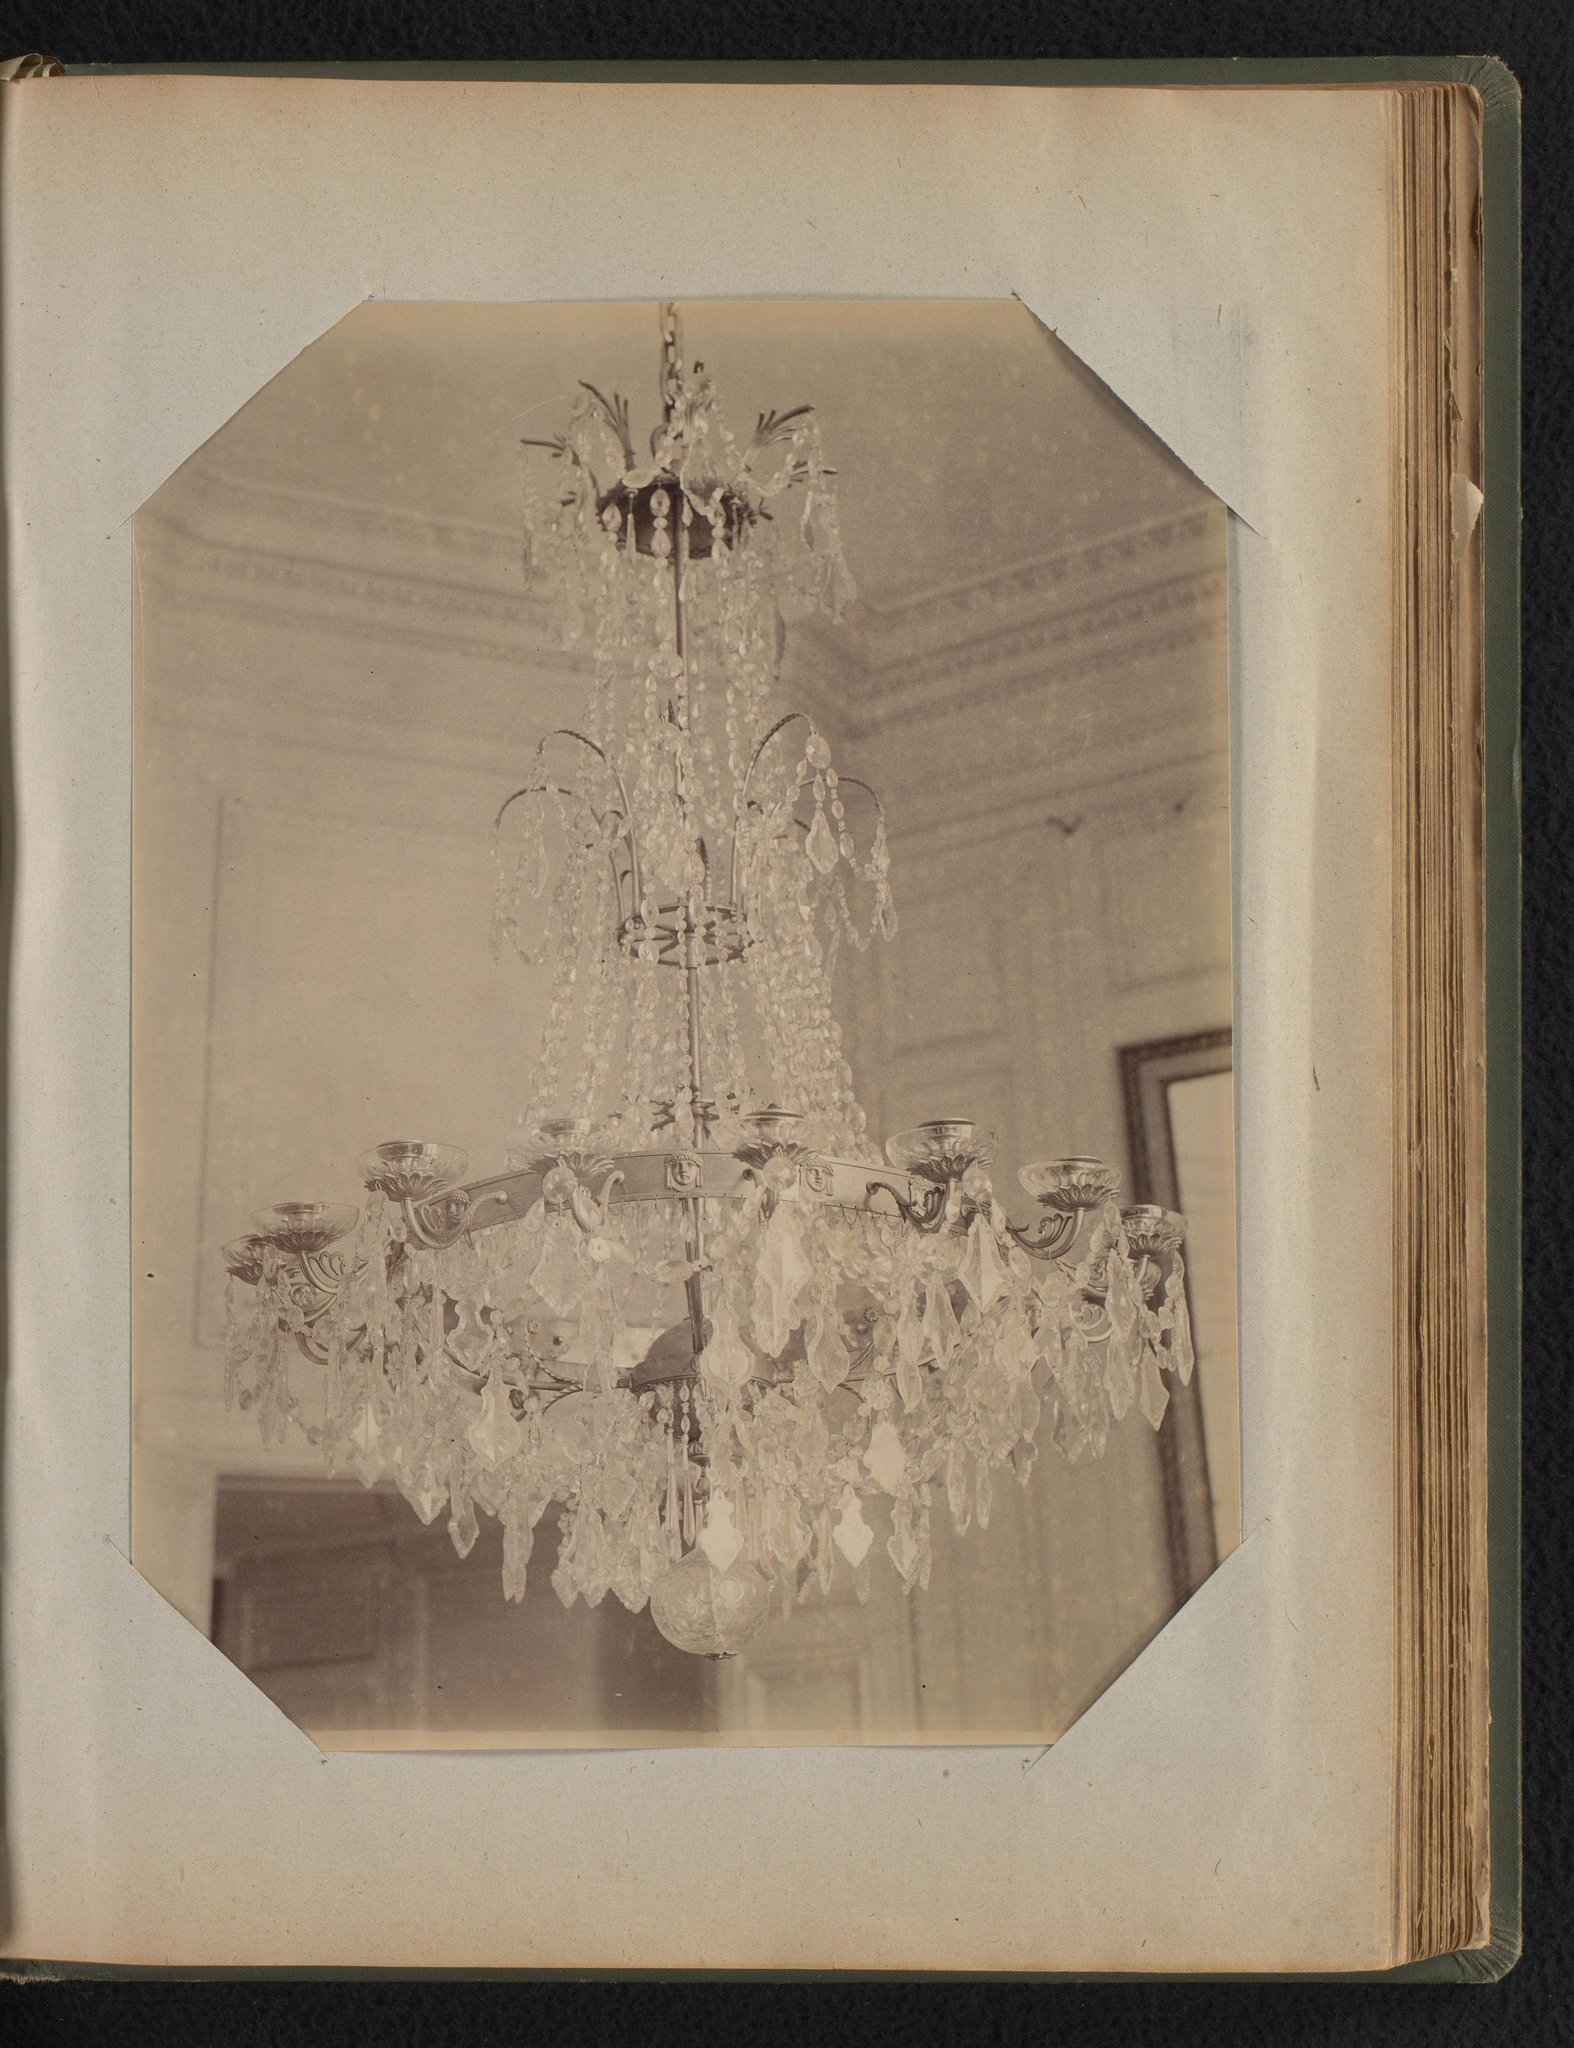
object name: photograph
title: Bronzen kroonluchter met kristallen ornamenten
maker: Anonymous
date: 1860-1900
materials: paper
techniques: albumen print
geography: netherlands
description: Op de ring met kandelaars zijn kleine bronzen hoofden aangebracht als ornament. Onderdeel van een serie met betrekking tot het interieur van het paleis van Versailles met kroonluchters, deuren, portalen en meubelstukken.